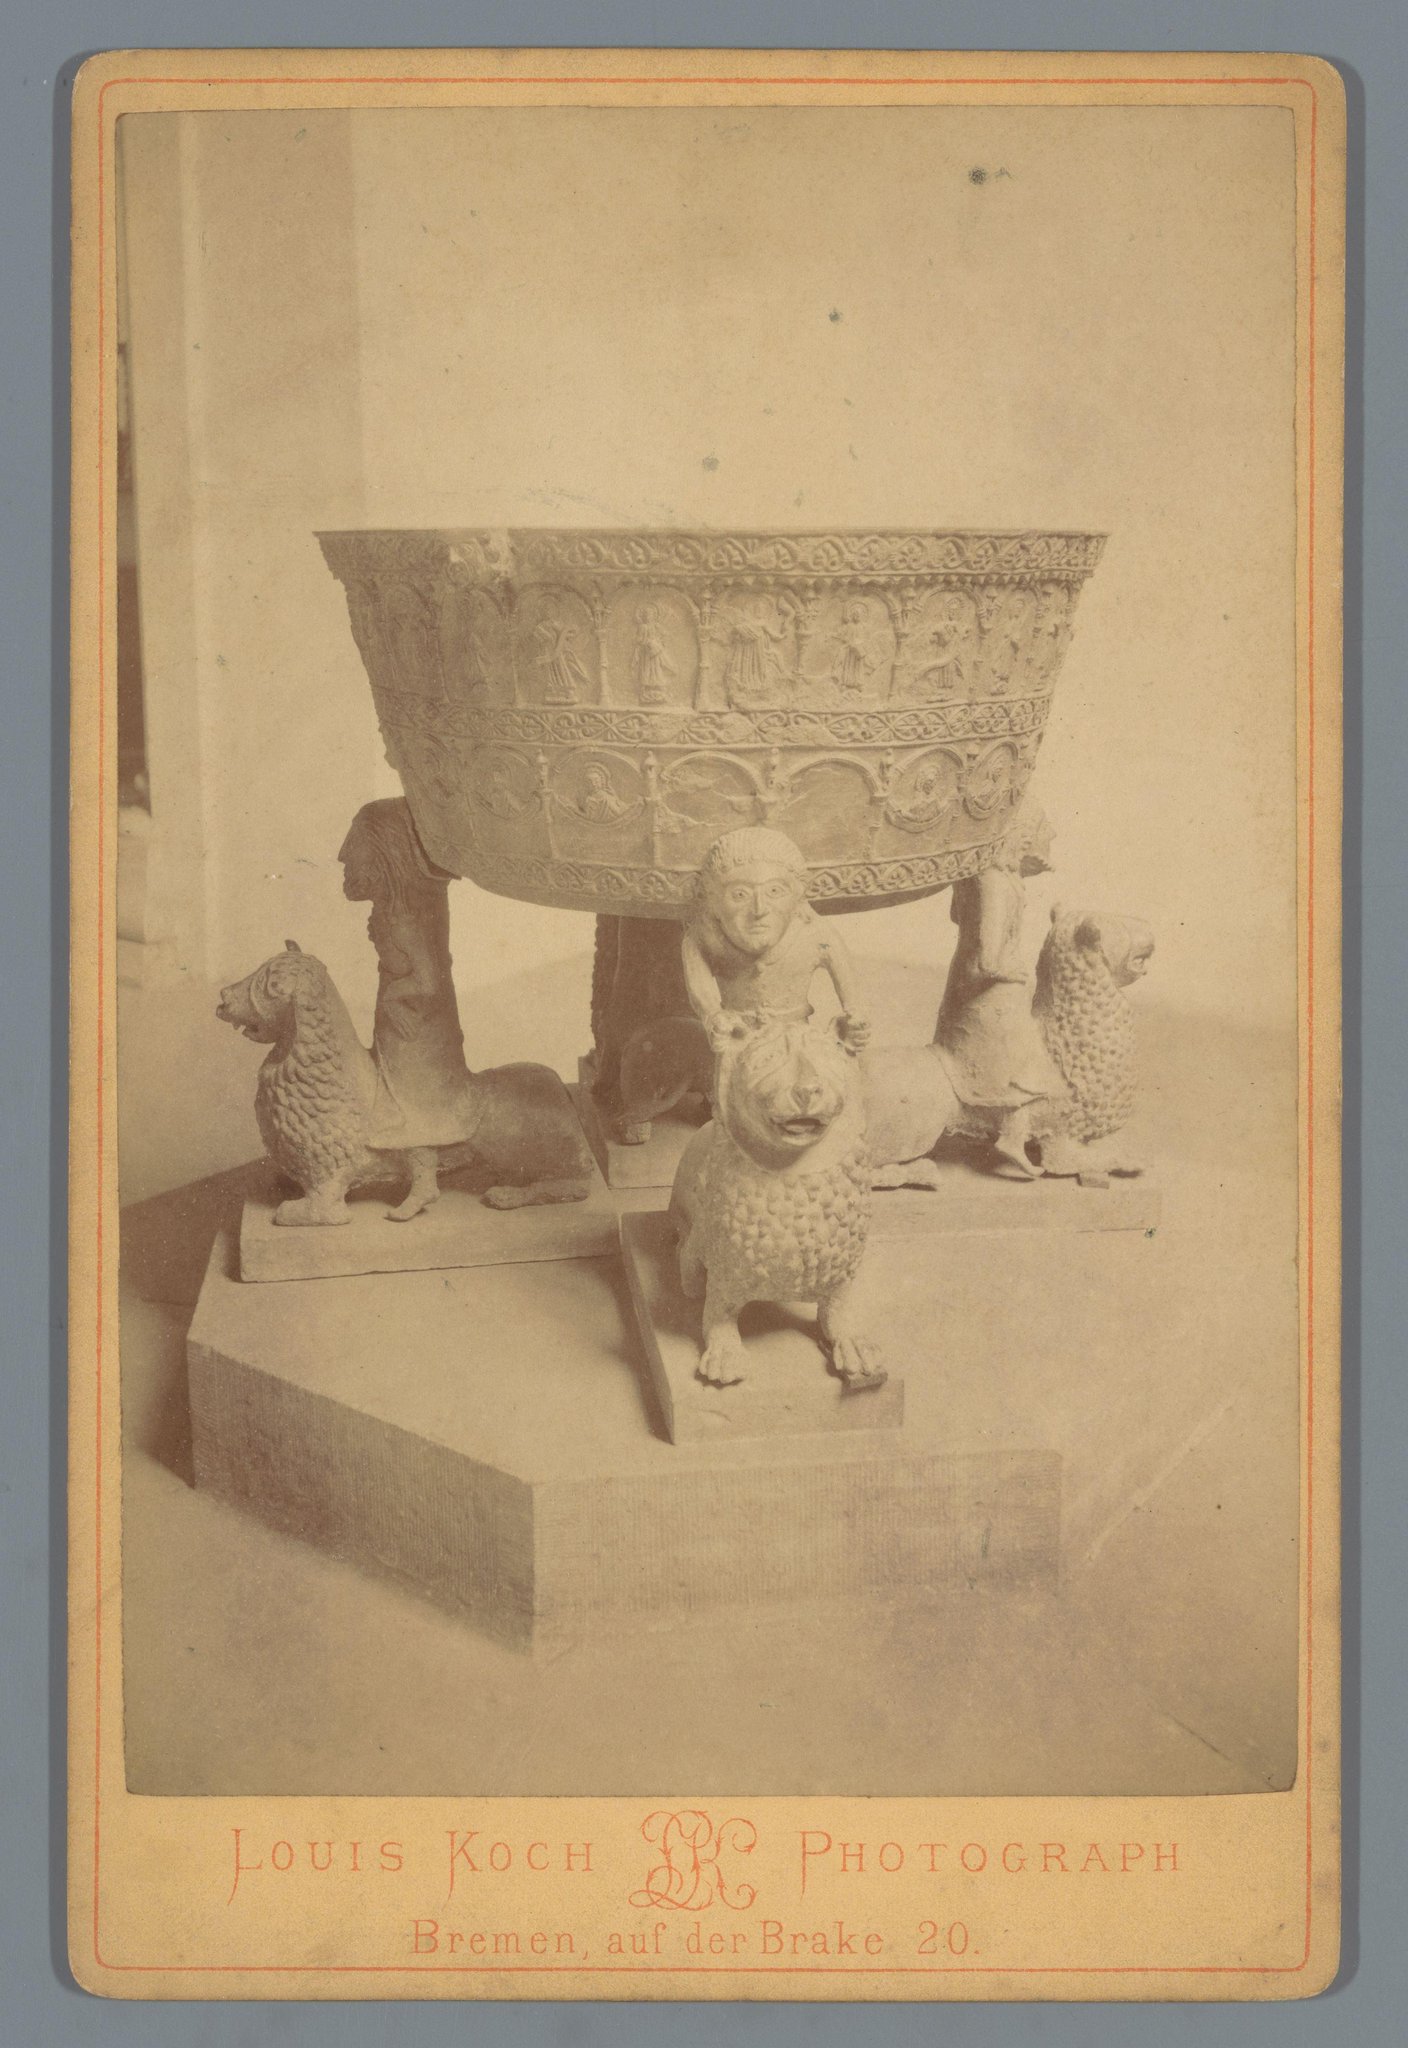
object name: cabinet photograph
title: Romaanse doopvont in de Dom van Bremen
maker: louis koch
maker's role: fotograaf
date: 1880-1900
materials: cardboard, photographic support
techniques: albumen print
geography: bremen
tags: holy water font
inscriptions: address: ‘Bremen, auf der Brake 20.’, annotation: ‘Romanischer Taufbecken/ Dom zu Bremen’